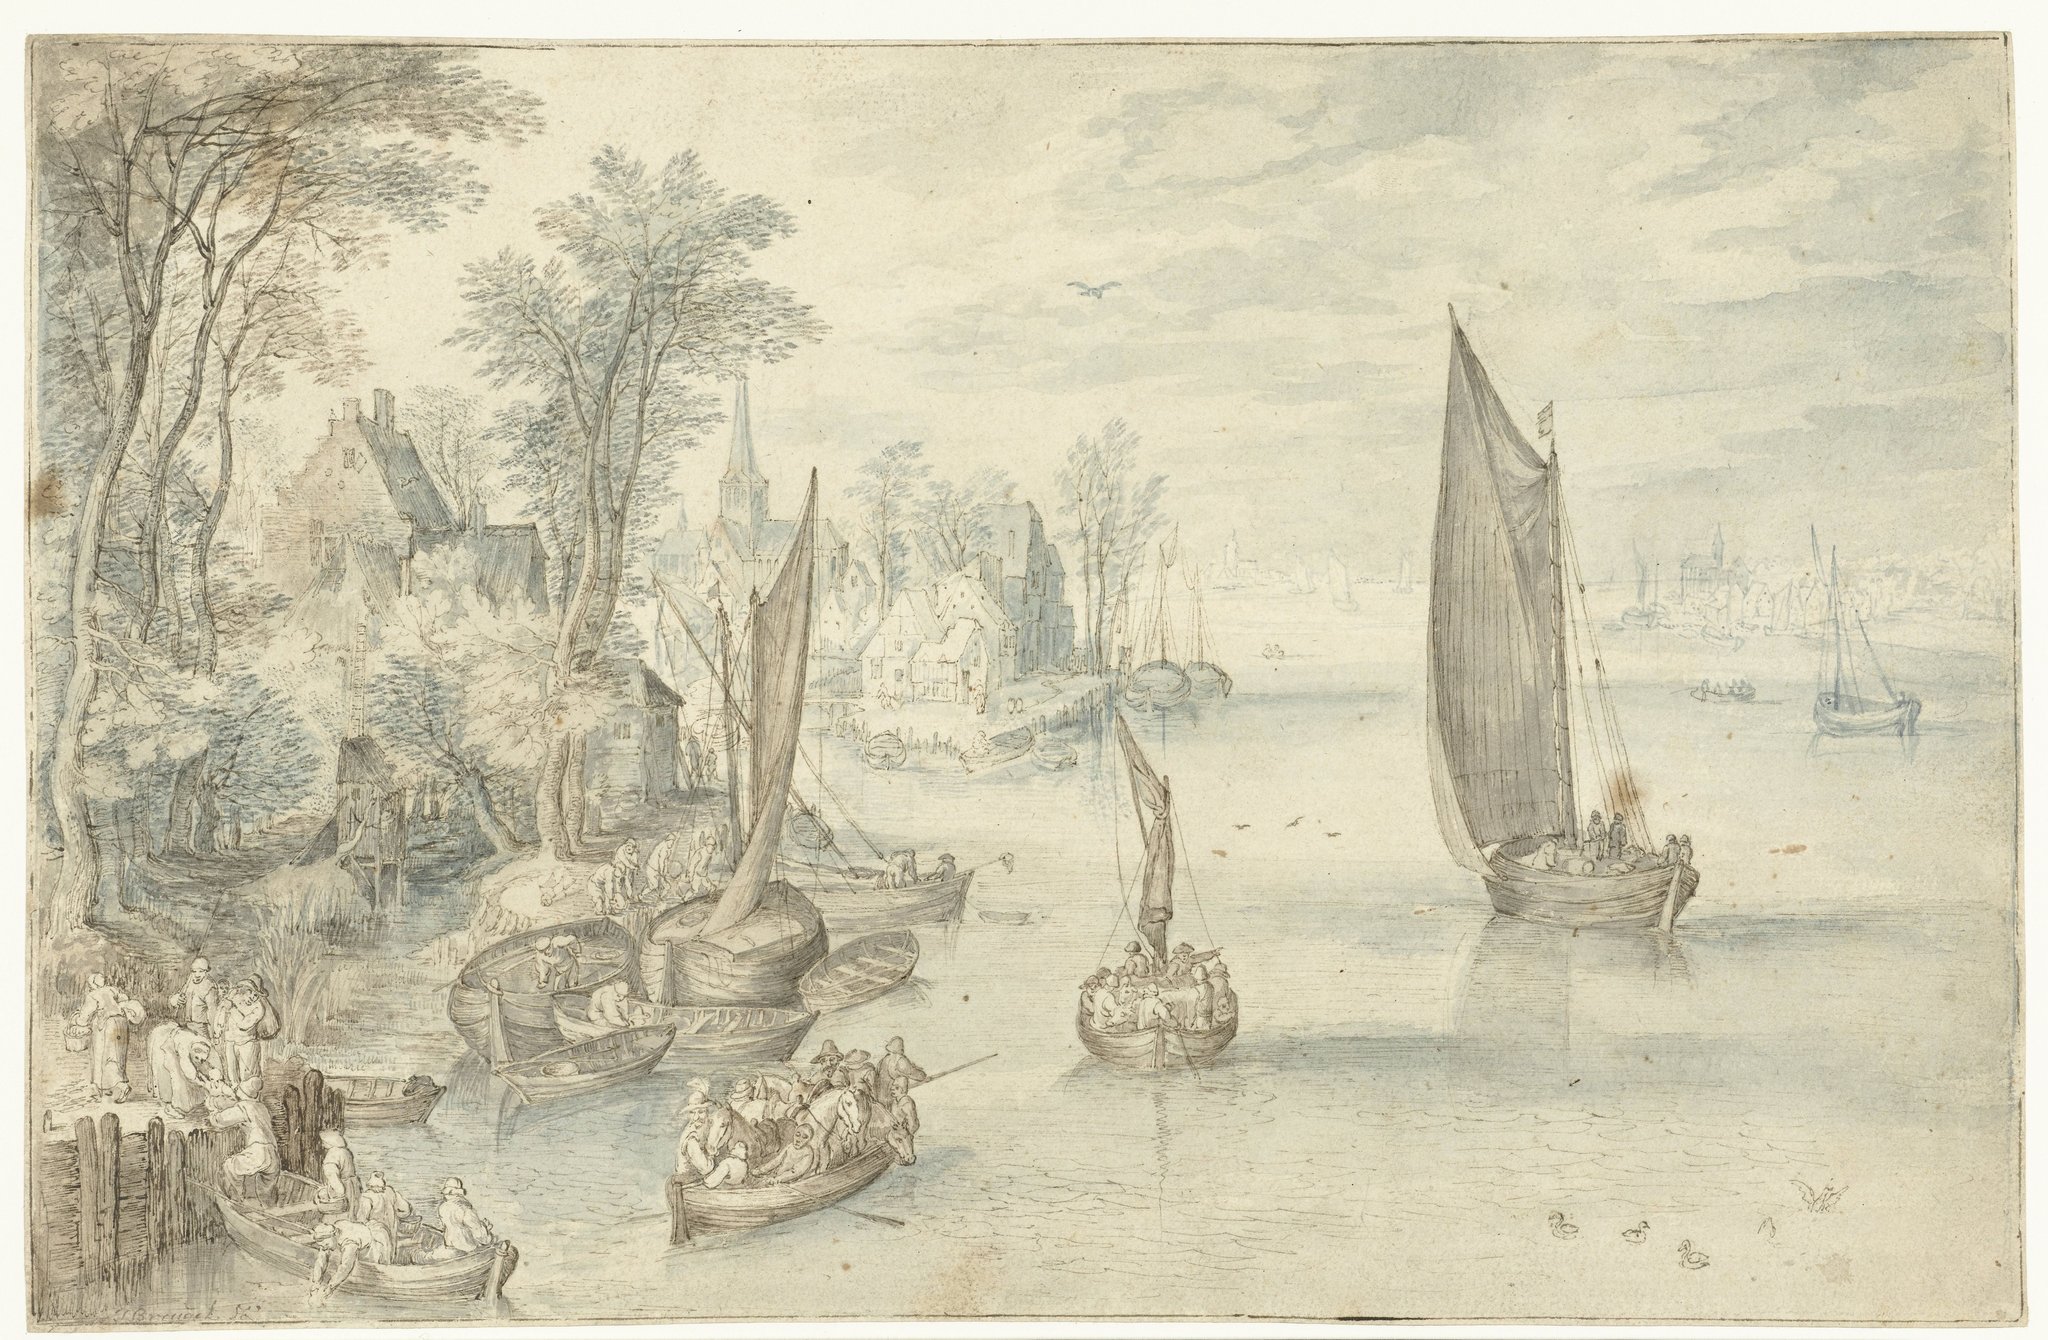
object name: drawing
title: Stad aan een brede rivier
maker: Anonymous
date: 1680-1720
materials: ink, paper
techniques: brush, pen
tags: sailing-ship, sailing-boat, river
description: Stad aan een brede rivier; op de voorgrond sloepen en zeilscheepjes.